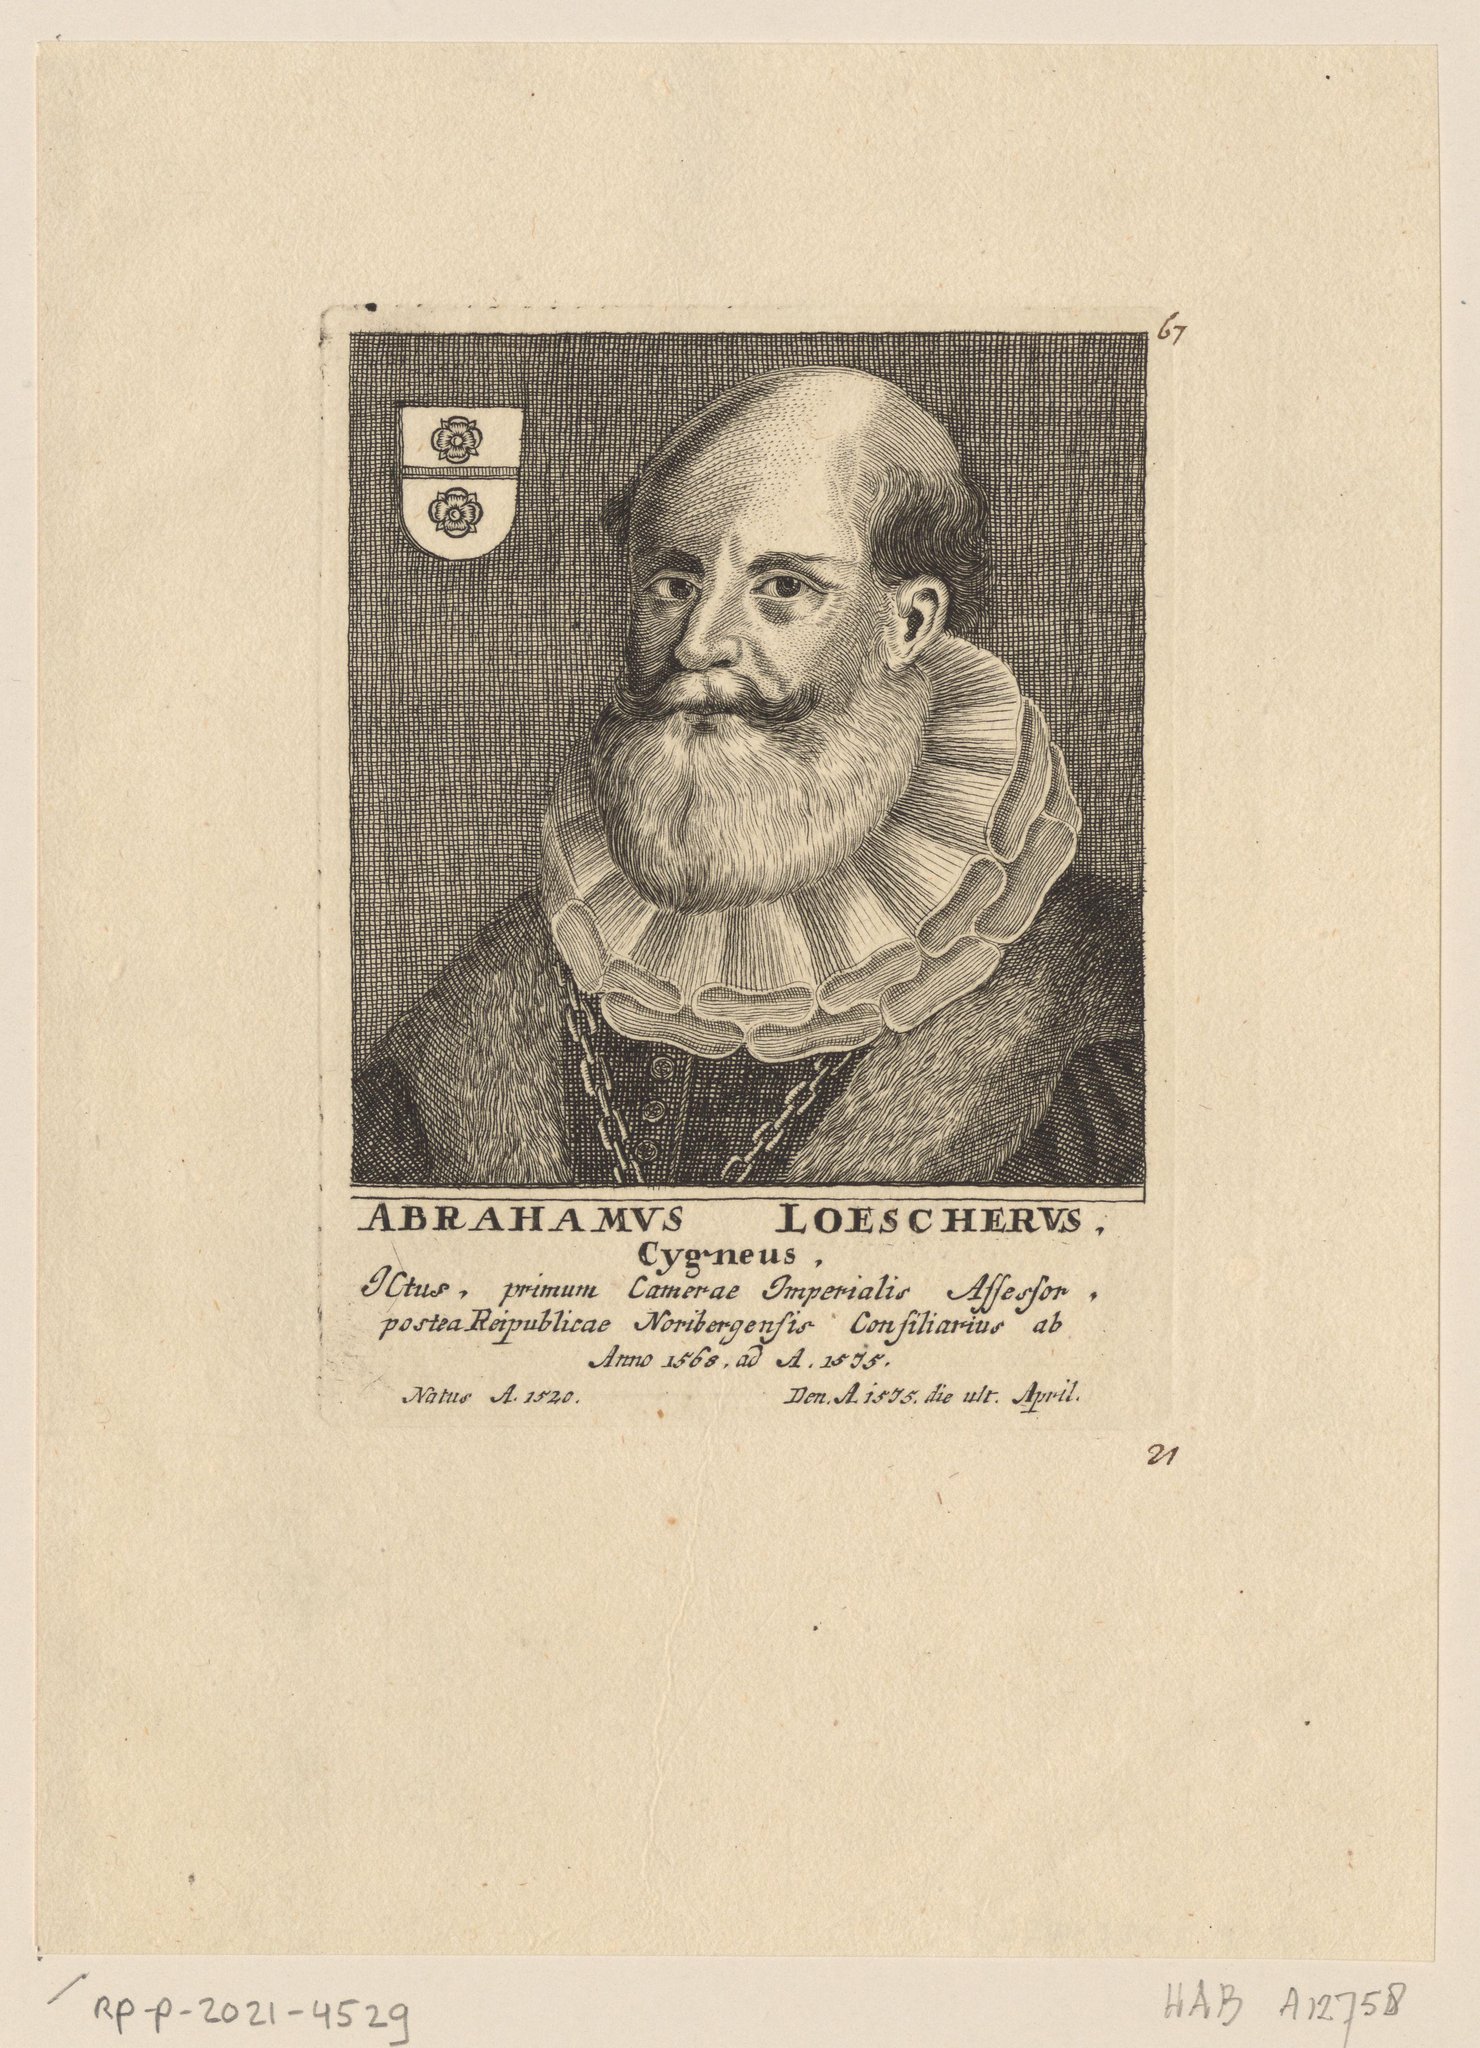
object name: print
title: Portret van Abraham Loescher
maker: Anonymous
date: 1723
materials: paper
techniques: engraving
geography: germany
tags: zwickau, historical persons, armorial bearing, heraldry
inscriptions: number: ‘21’, number: ‘67’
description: Prent waarschijnlijk uit: Rothscholtz, Friedrich. Icones consiliariorum de illustri republica Noribergensi (...). Neurenberg en Altdorf: erven Johann Daniel Tauber, 1723.